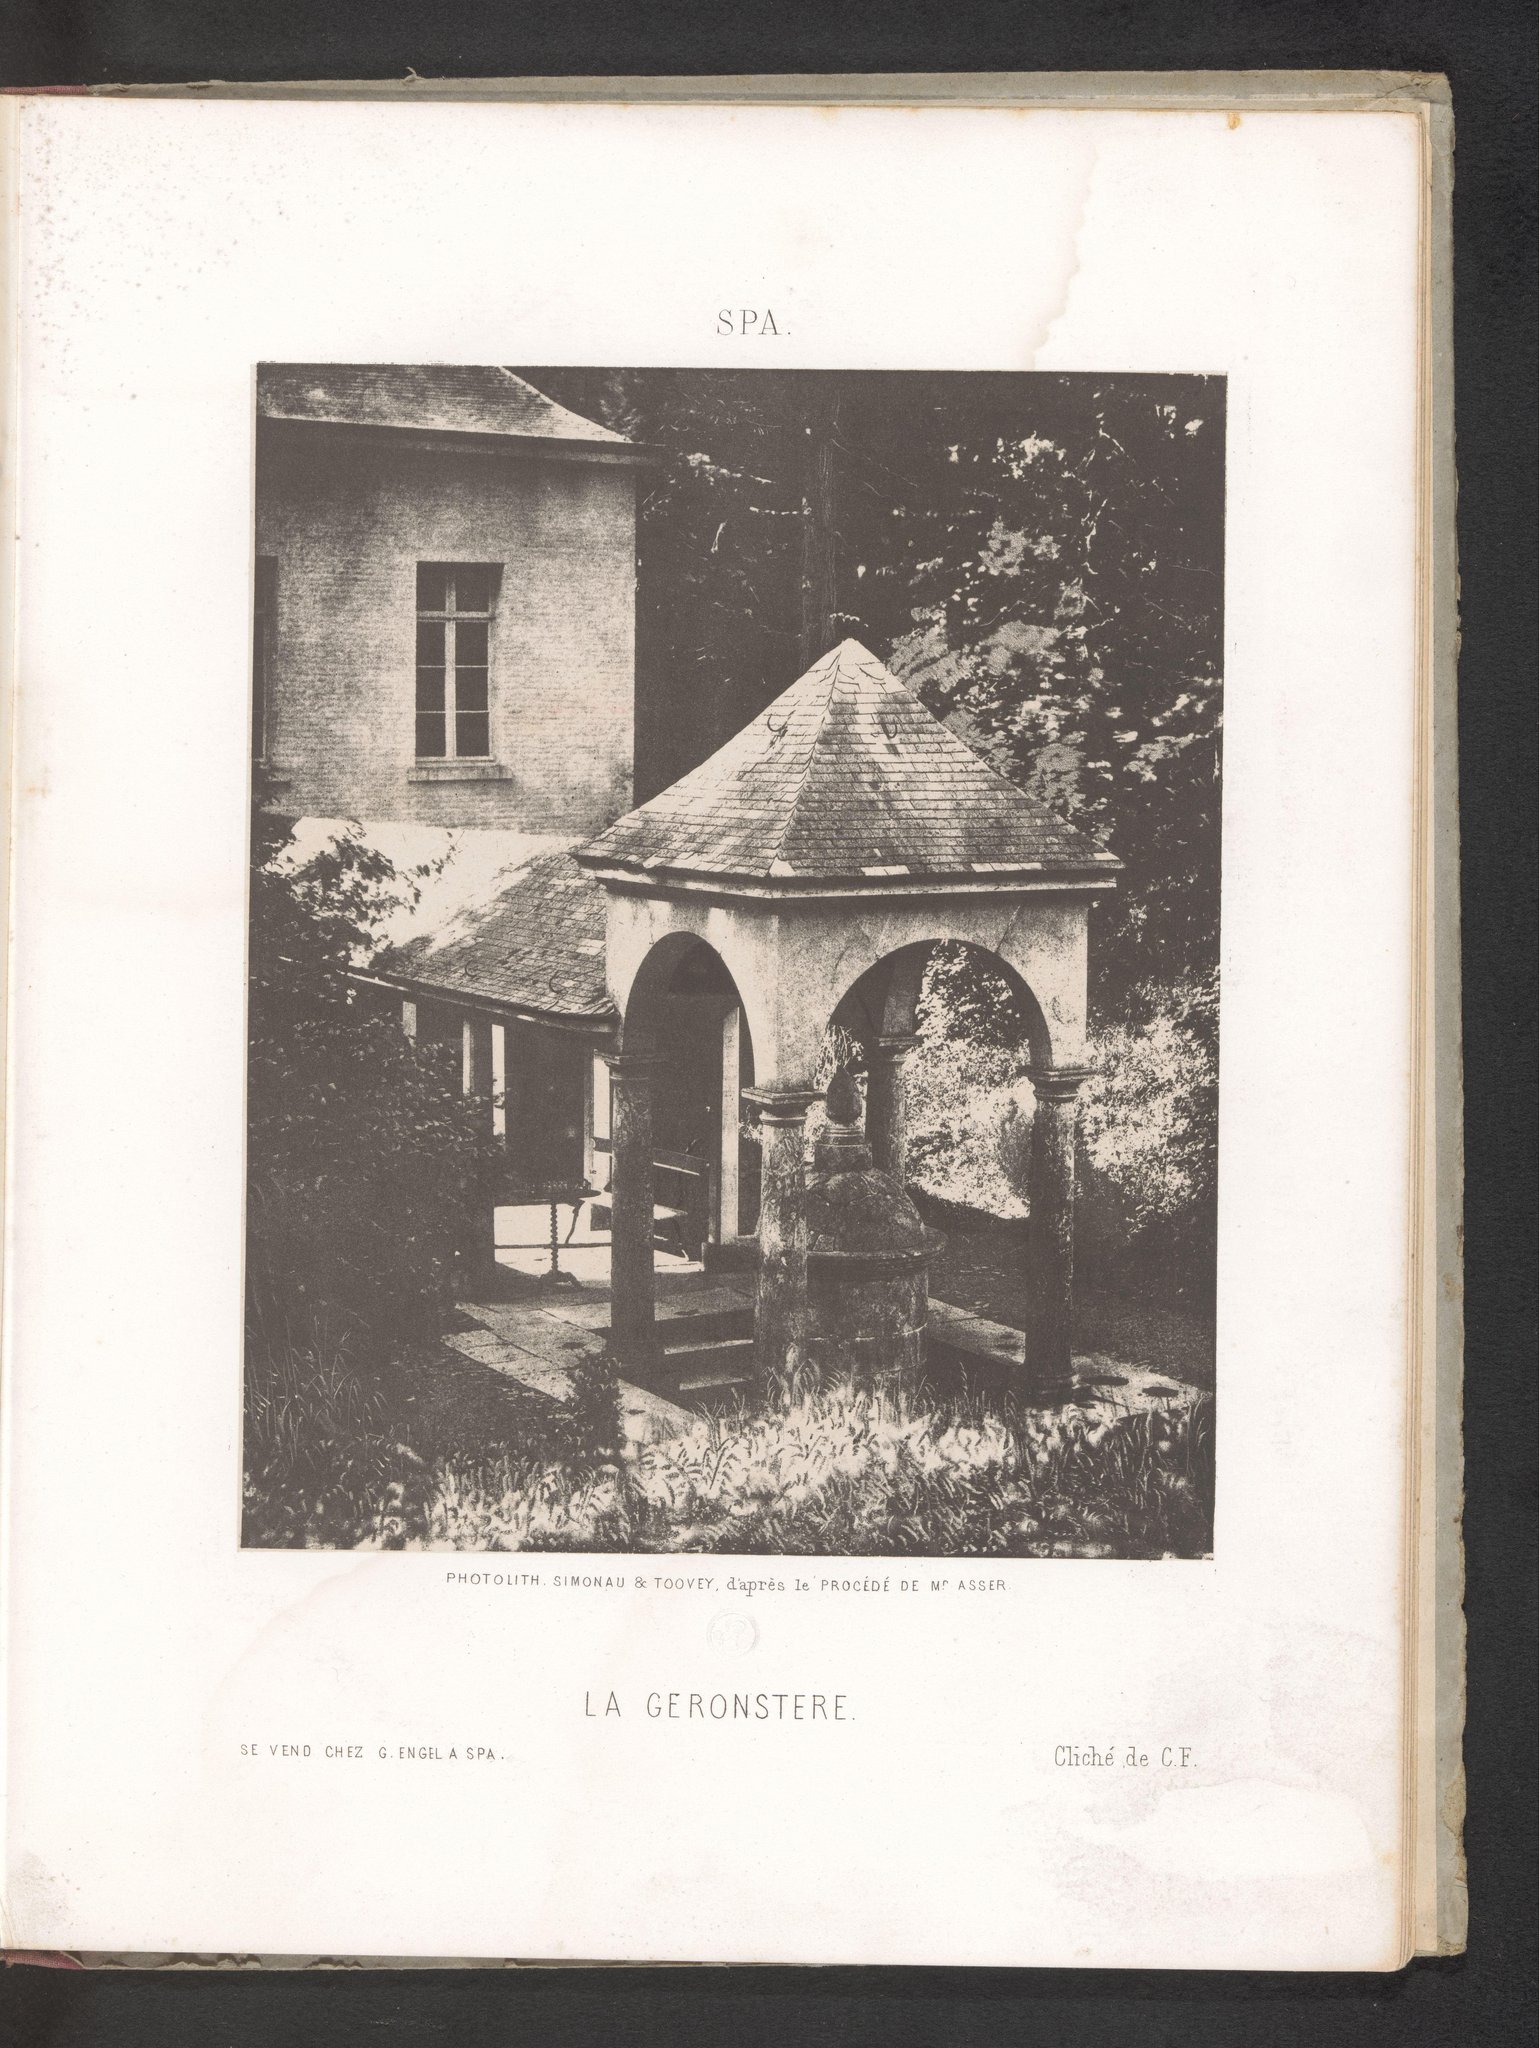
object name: photomechanical print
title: La Geronstere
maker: c.f.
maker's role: fotograaf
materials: paper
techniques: photolithography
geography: spa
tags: spring (fluids extracted from the earth)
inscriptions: collector's mark: ‘EA’, inscription: ‘PHOTOLITH. SIMONAU & TOOVEY, d'après le procédé de Mr. ASSER.’, inscription: ‘SE VEND CHEZ F. ENGEL A SPA.’